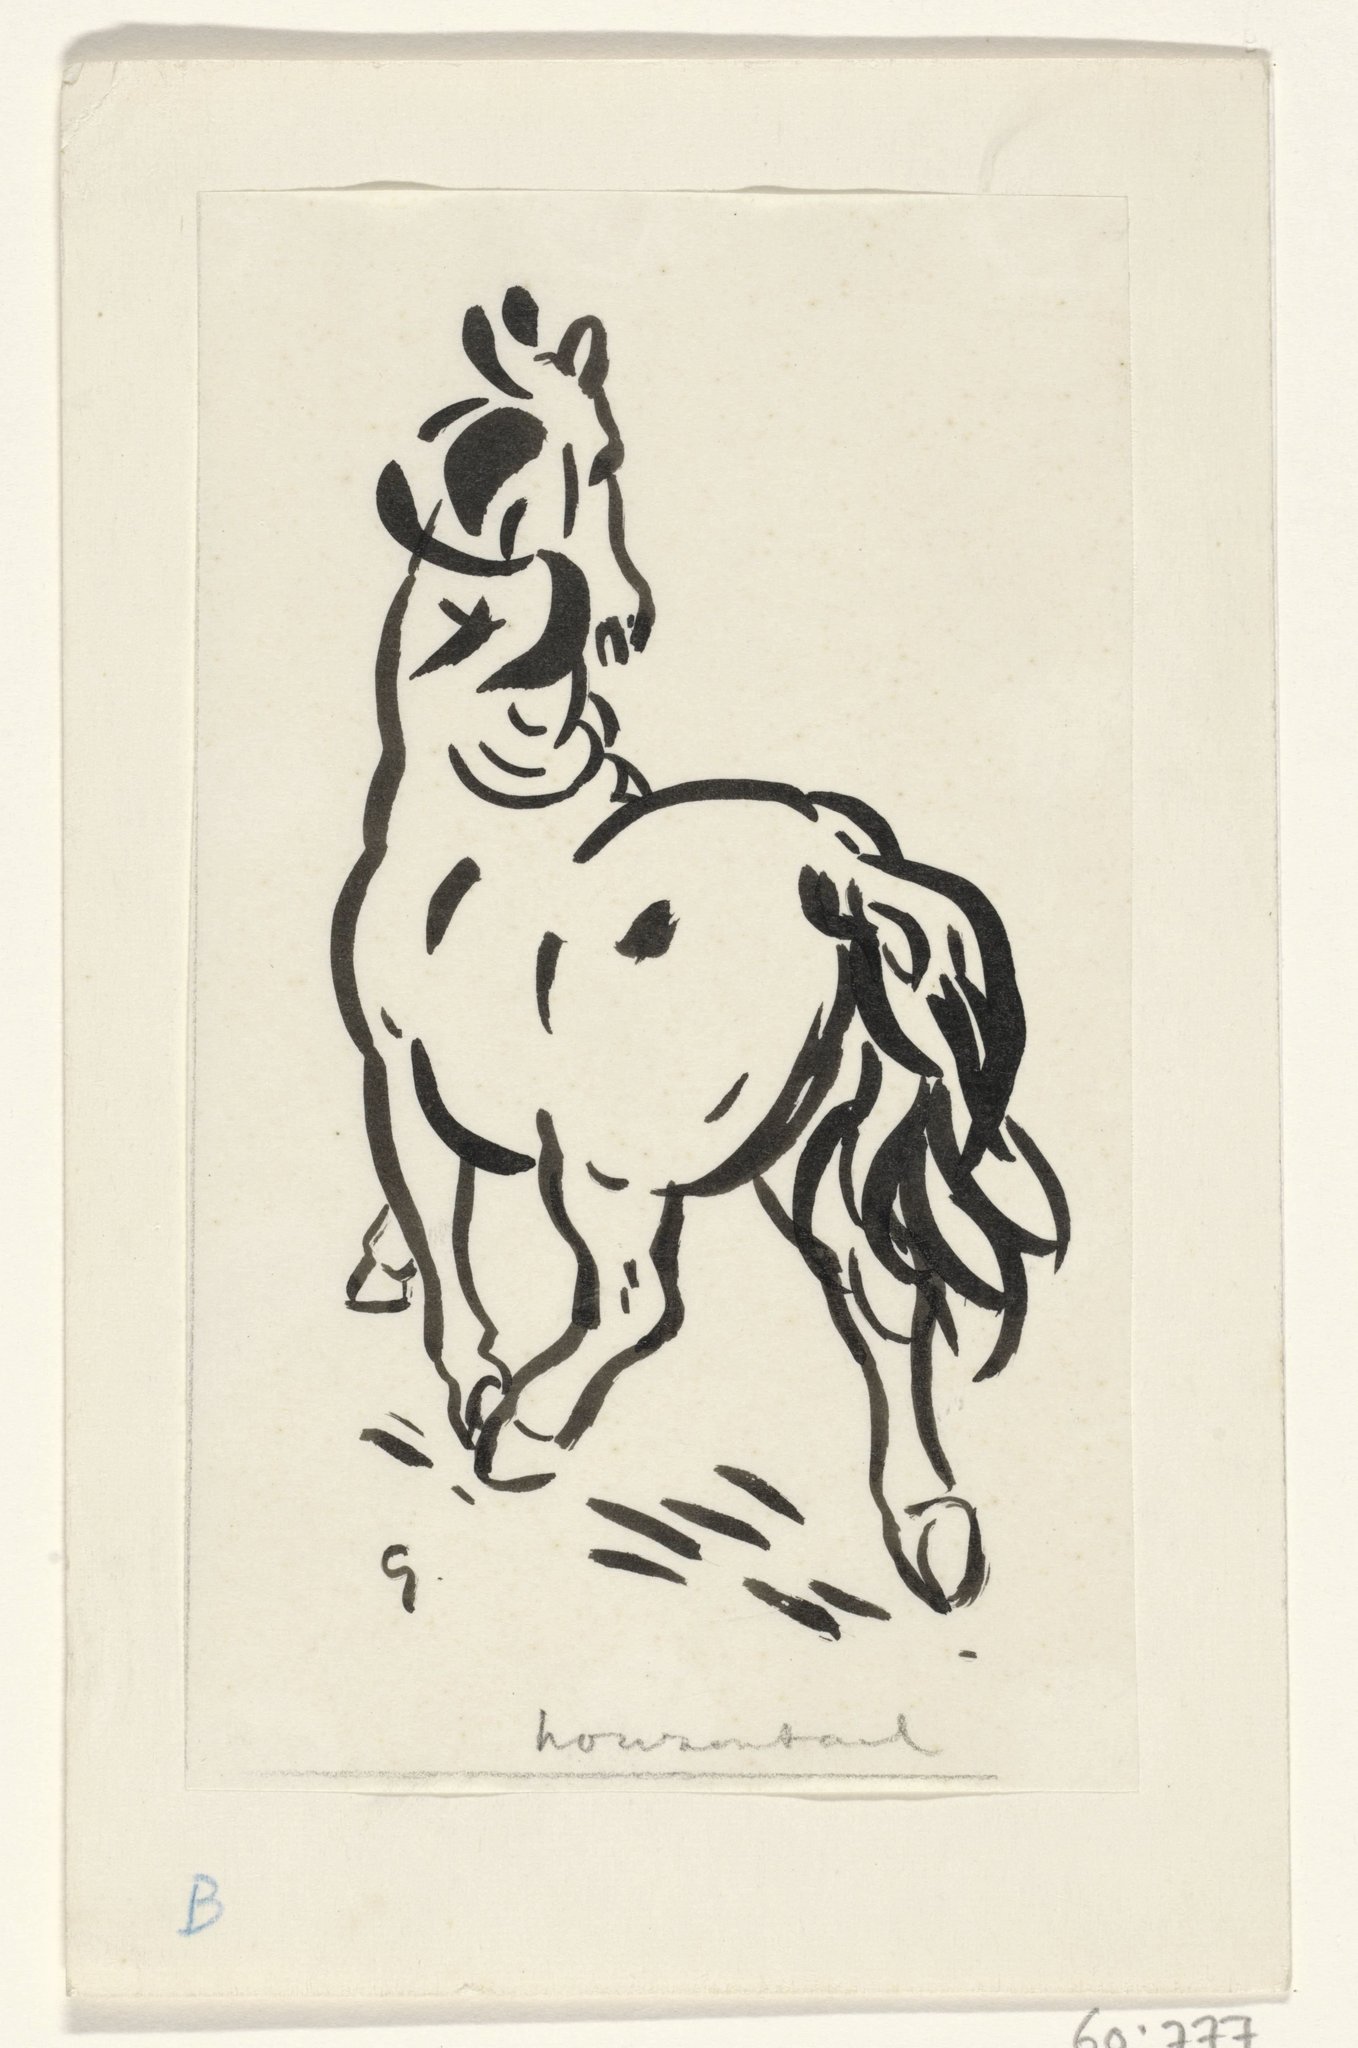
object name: design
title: Paard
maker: leo gestel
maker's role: draughtsman, print maker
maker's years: 1881-1941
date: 1938-1940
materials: ink, paper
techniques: brush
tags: horse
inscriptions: collector's mark: Lugt 2228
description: Ontwerp voor een illustratie voor: De Gemeenschap 16, 1940.